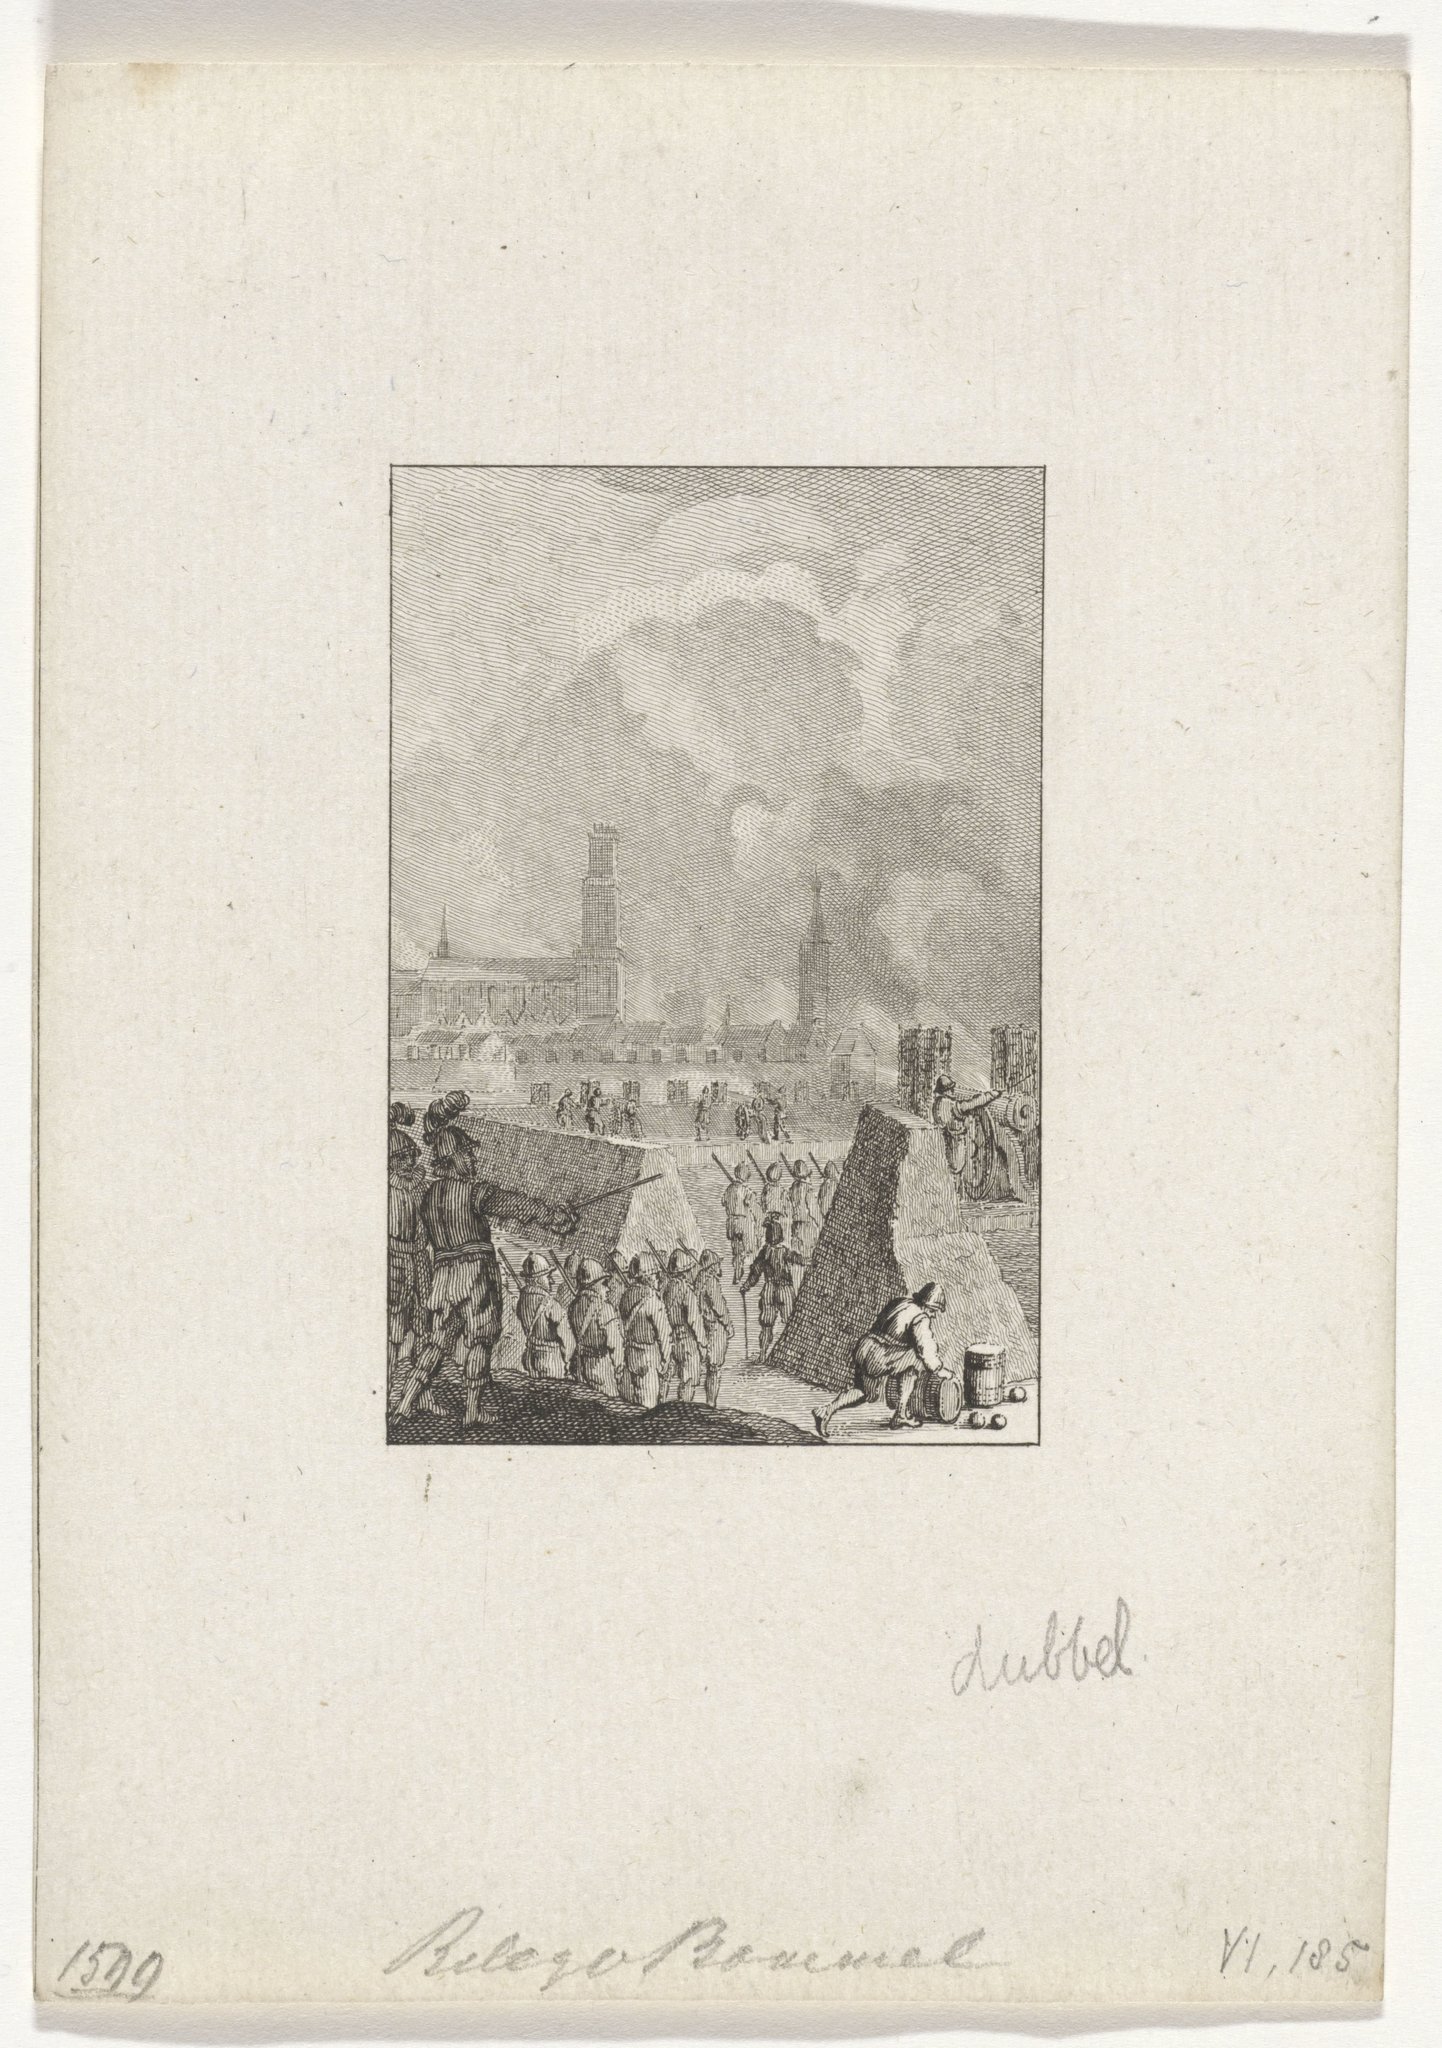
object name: print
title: Beleg van Zaltbommel, 1599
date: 1783-1795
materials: paper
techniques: etching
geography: amsterdam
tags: the hague, maurice (prince of orange), siege, position war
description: De belegering van de stad Zaltbommel door het Spaanse leger onder Mendoza en verdedigd door het Staatse leger onder Maurits, mei-juni 1599. Gezien vanuit de stellingen van de belegeraars.